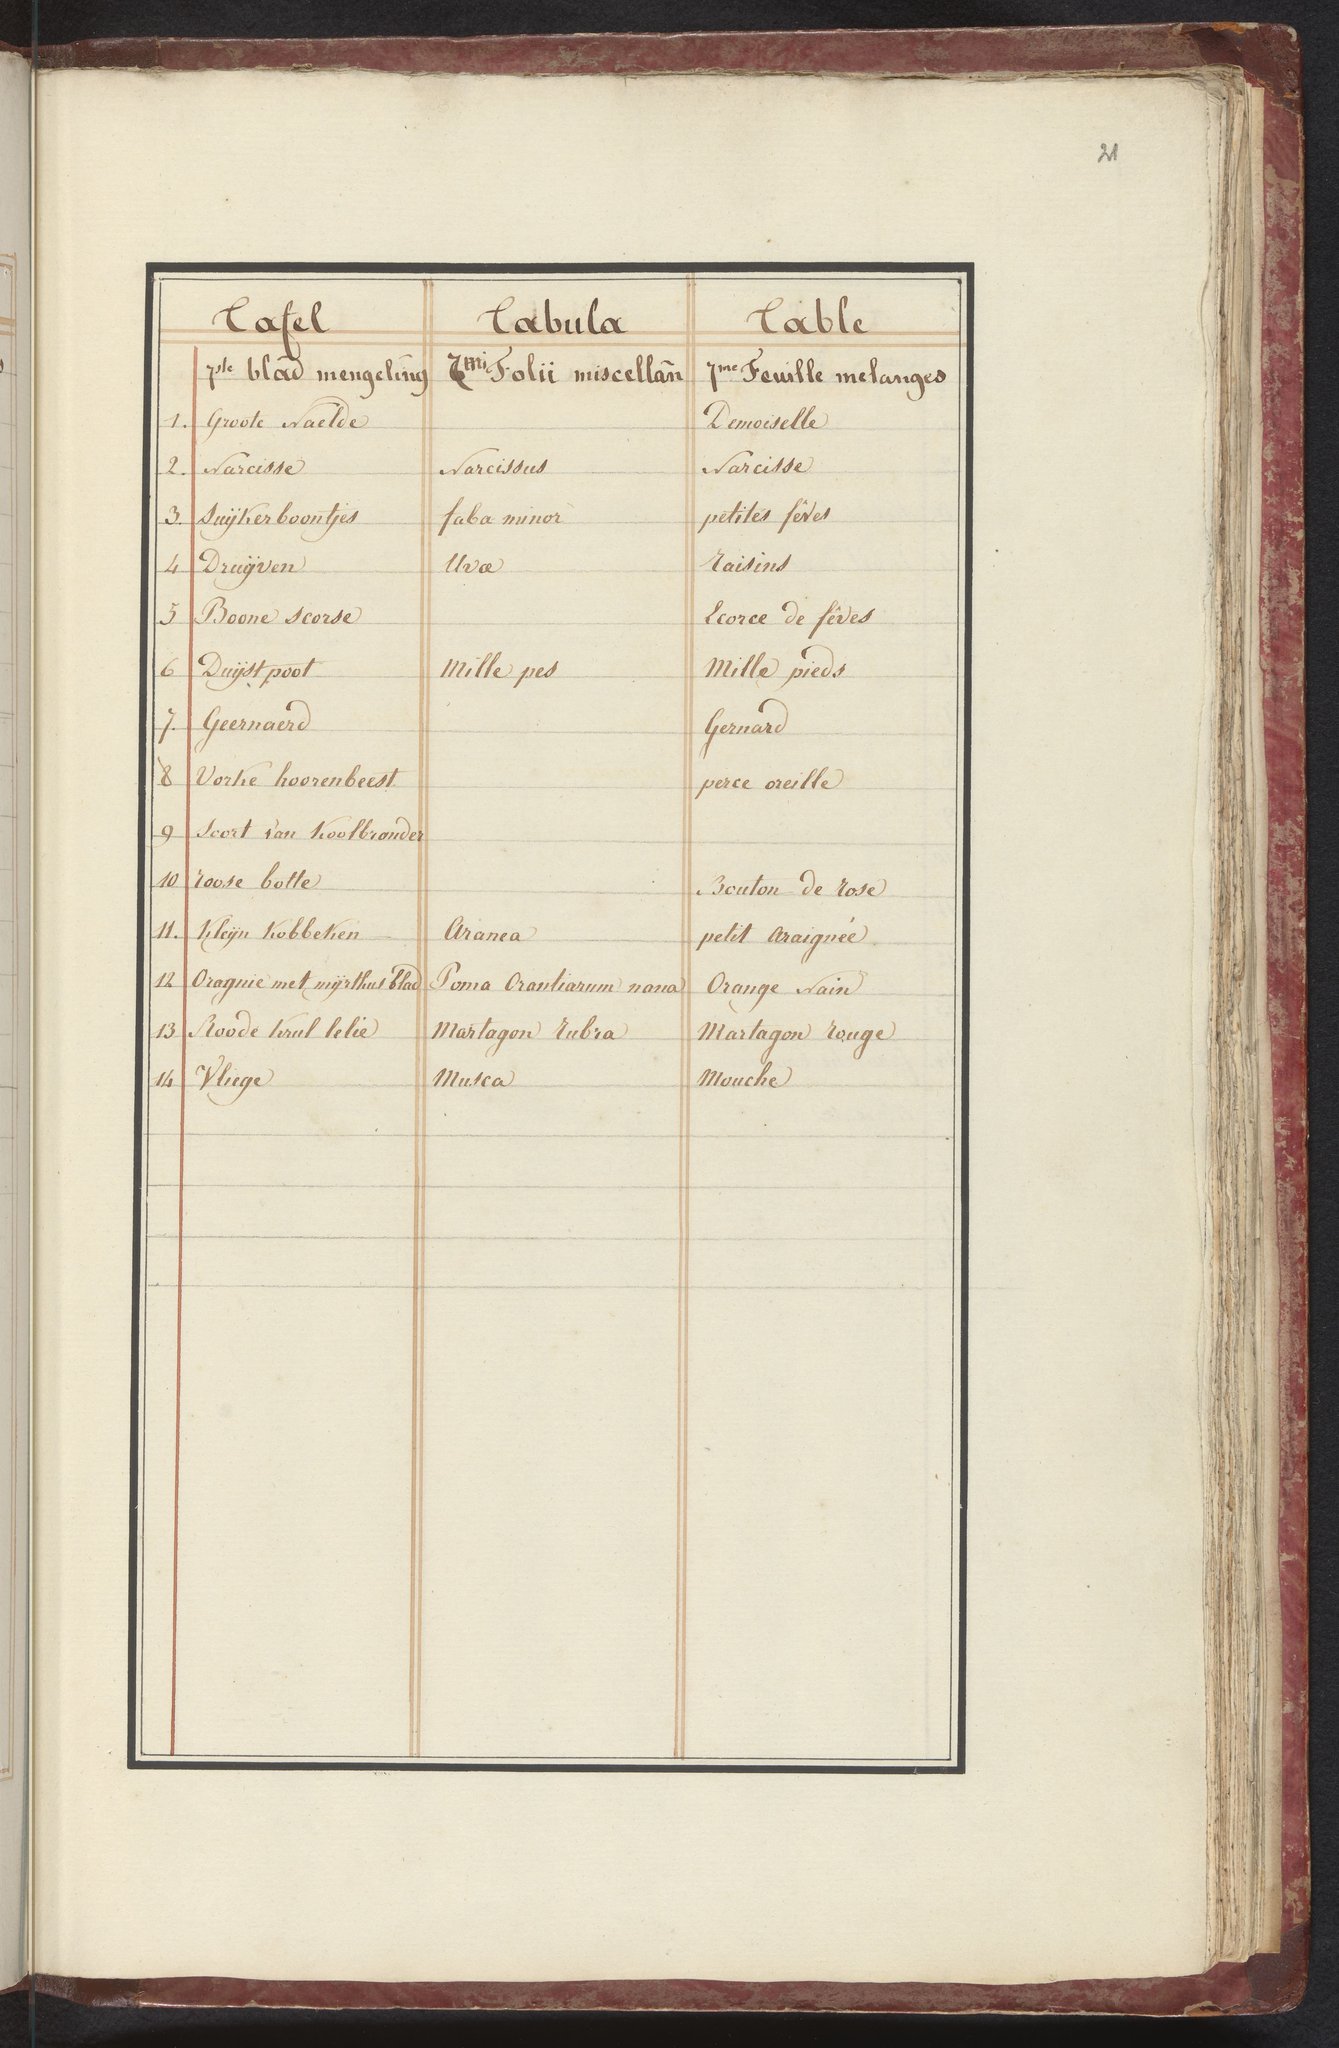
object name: manuscript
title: Tafel 7ste blad mengeling / Tabula 7mi Folii miscellan. / Table 7me Feuille melanges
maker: joseph van huerne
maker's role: kunstliefhebber, mecenas, verzamelaar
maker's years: 1752-1844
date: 1809-1814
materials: ink, paper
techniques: handwriting, pen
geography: bruges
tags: handwriting, written text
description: Schema met een lijst in drie kolommen van de dieren en planten afgebeeld in het zevende ensemble, nummers 1-14. Onderdeel van het zevende album met tekeningen van reptielen, amfibieën en natuurhistorische ensembles. Het zevende van twaalf albums met aquarellen van dieren, vogels en planten bekend rond 1600, gemaakt in opdracht van keizer Rudolf II. Met toelichting in Nederlands, Latijn en Frans.